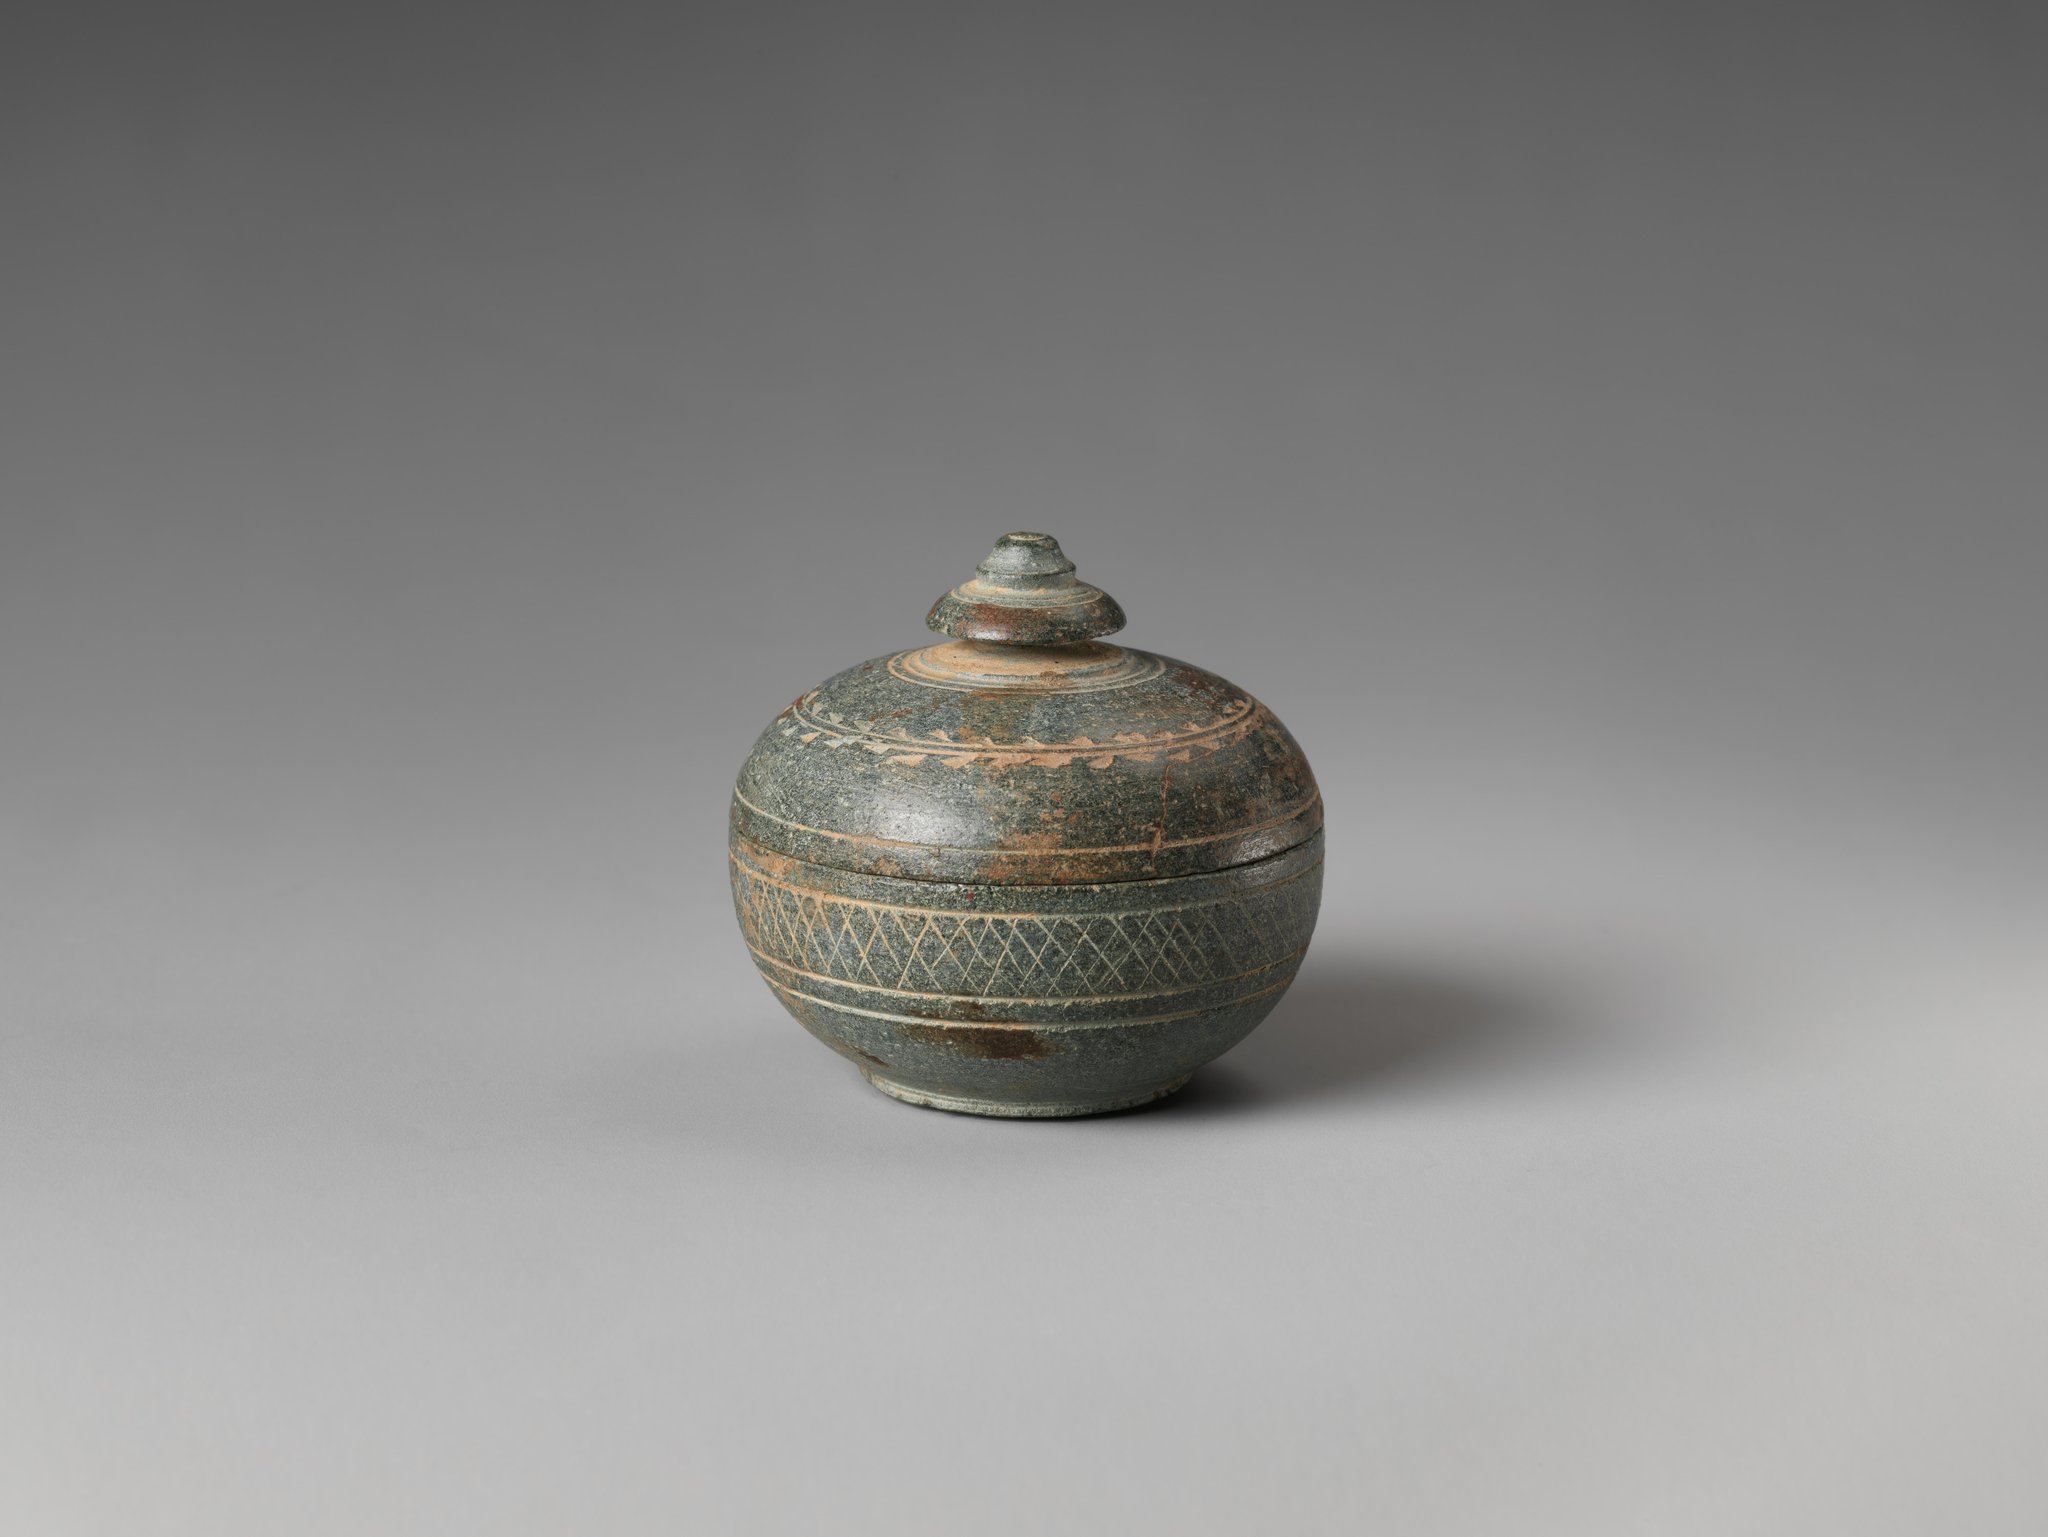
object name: reliquary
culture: gandhara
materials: stone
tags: gandhara